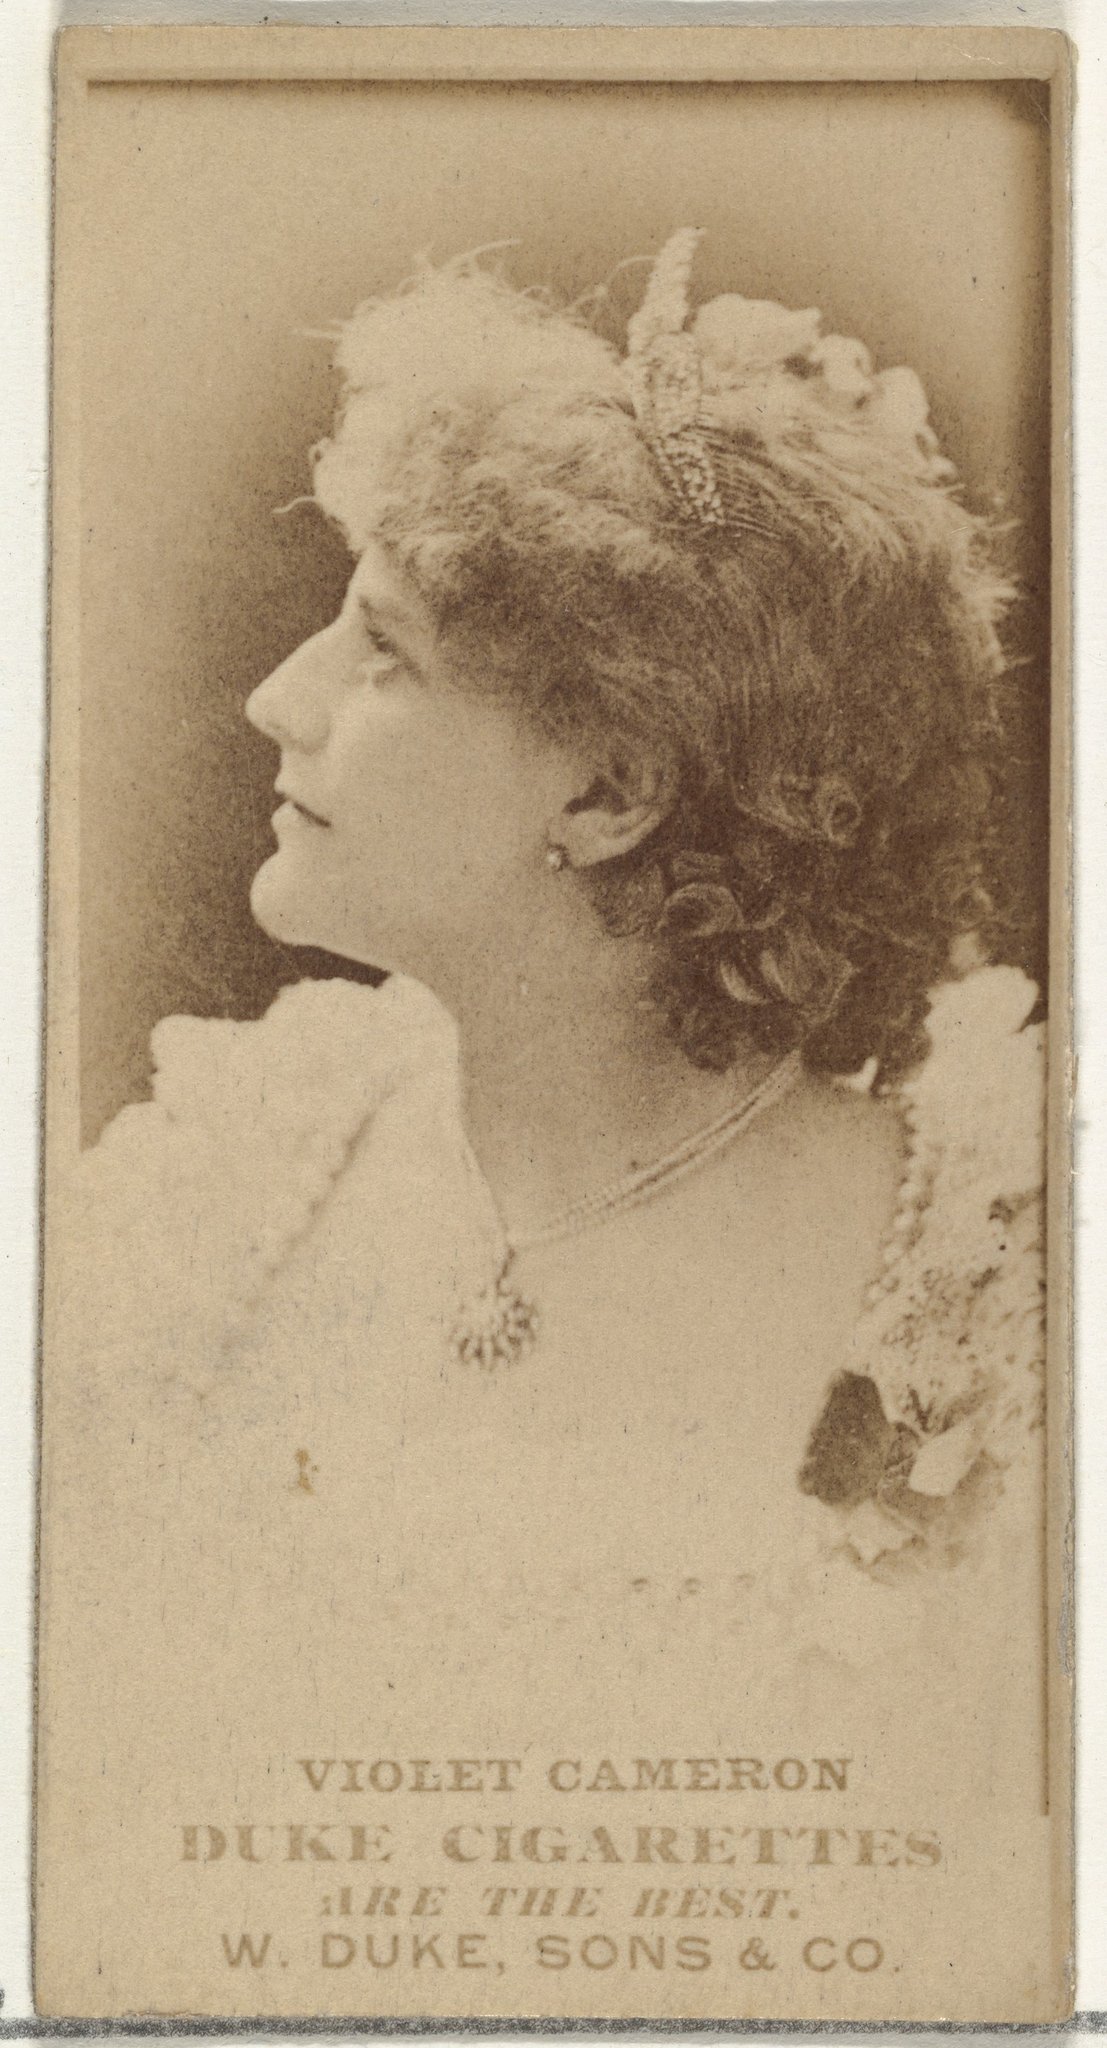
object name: photograph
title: Violet Cameron, from the Actors and Actresses series (N145-7) issued by Duke Sons & Co. to promote Duke Cigarettes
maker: w. duke, sons & co.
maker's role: publisher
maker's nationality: american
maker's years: 1870-1920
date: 1880-1889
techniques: albumen silver print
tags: women,actresses